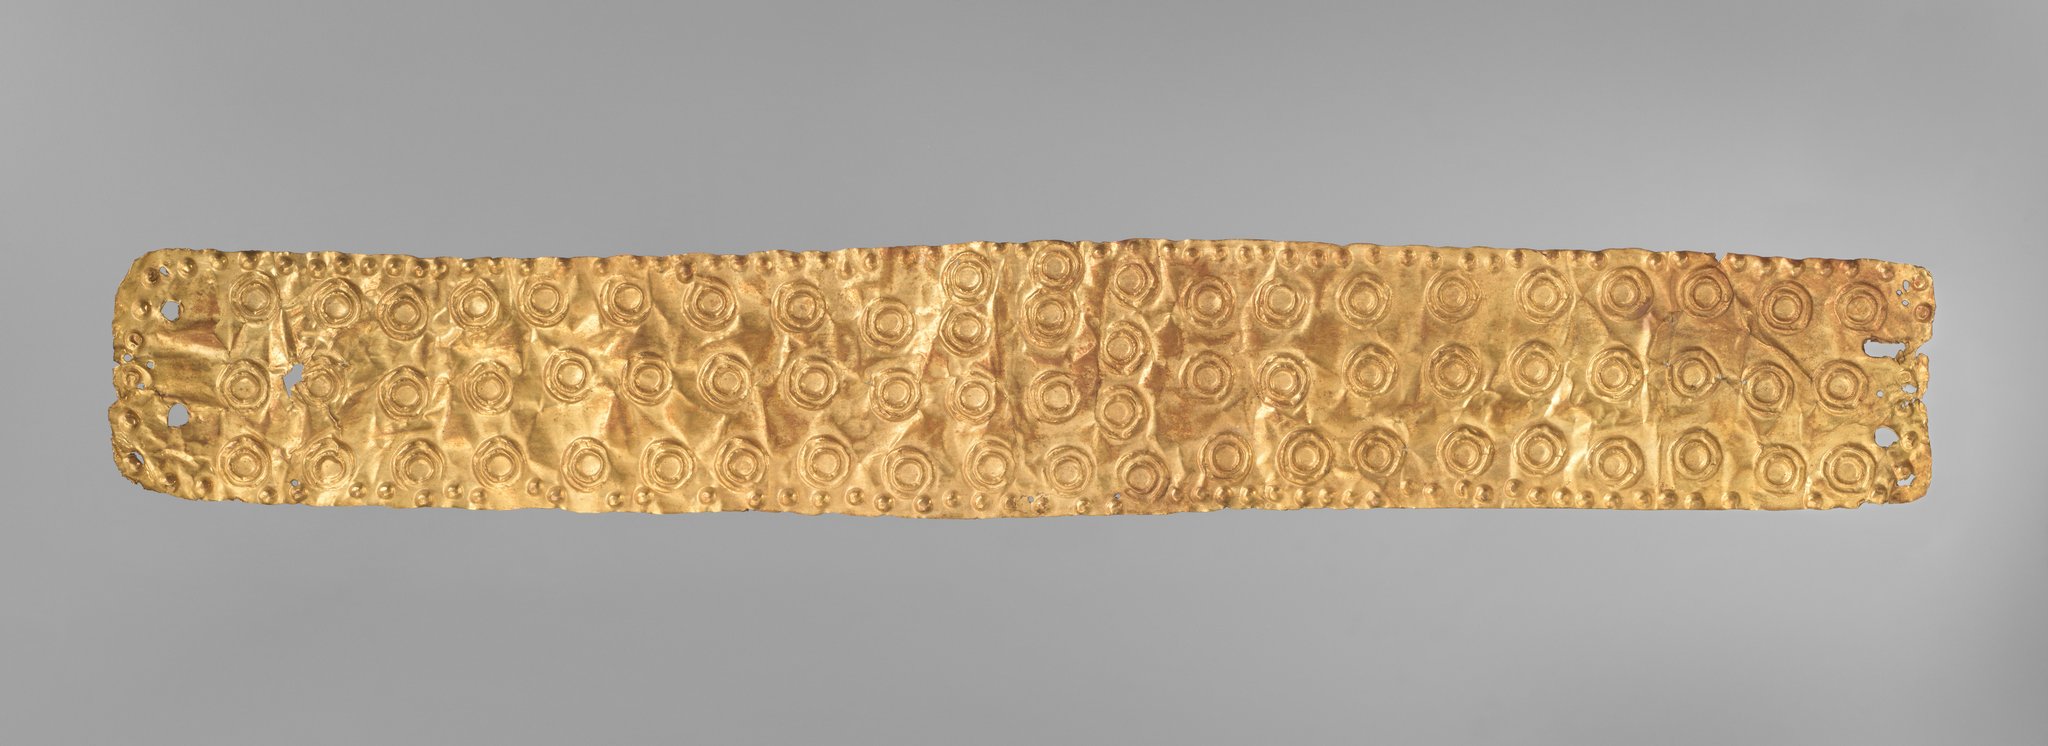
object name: frontlet of thin leaf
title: Gold frontlet of thin leaf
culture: cypriot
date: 1450-1200 BCE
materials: gold